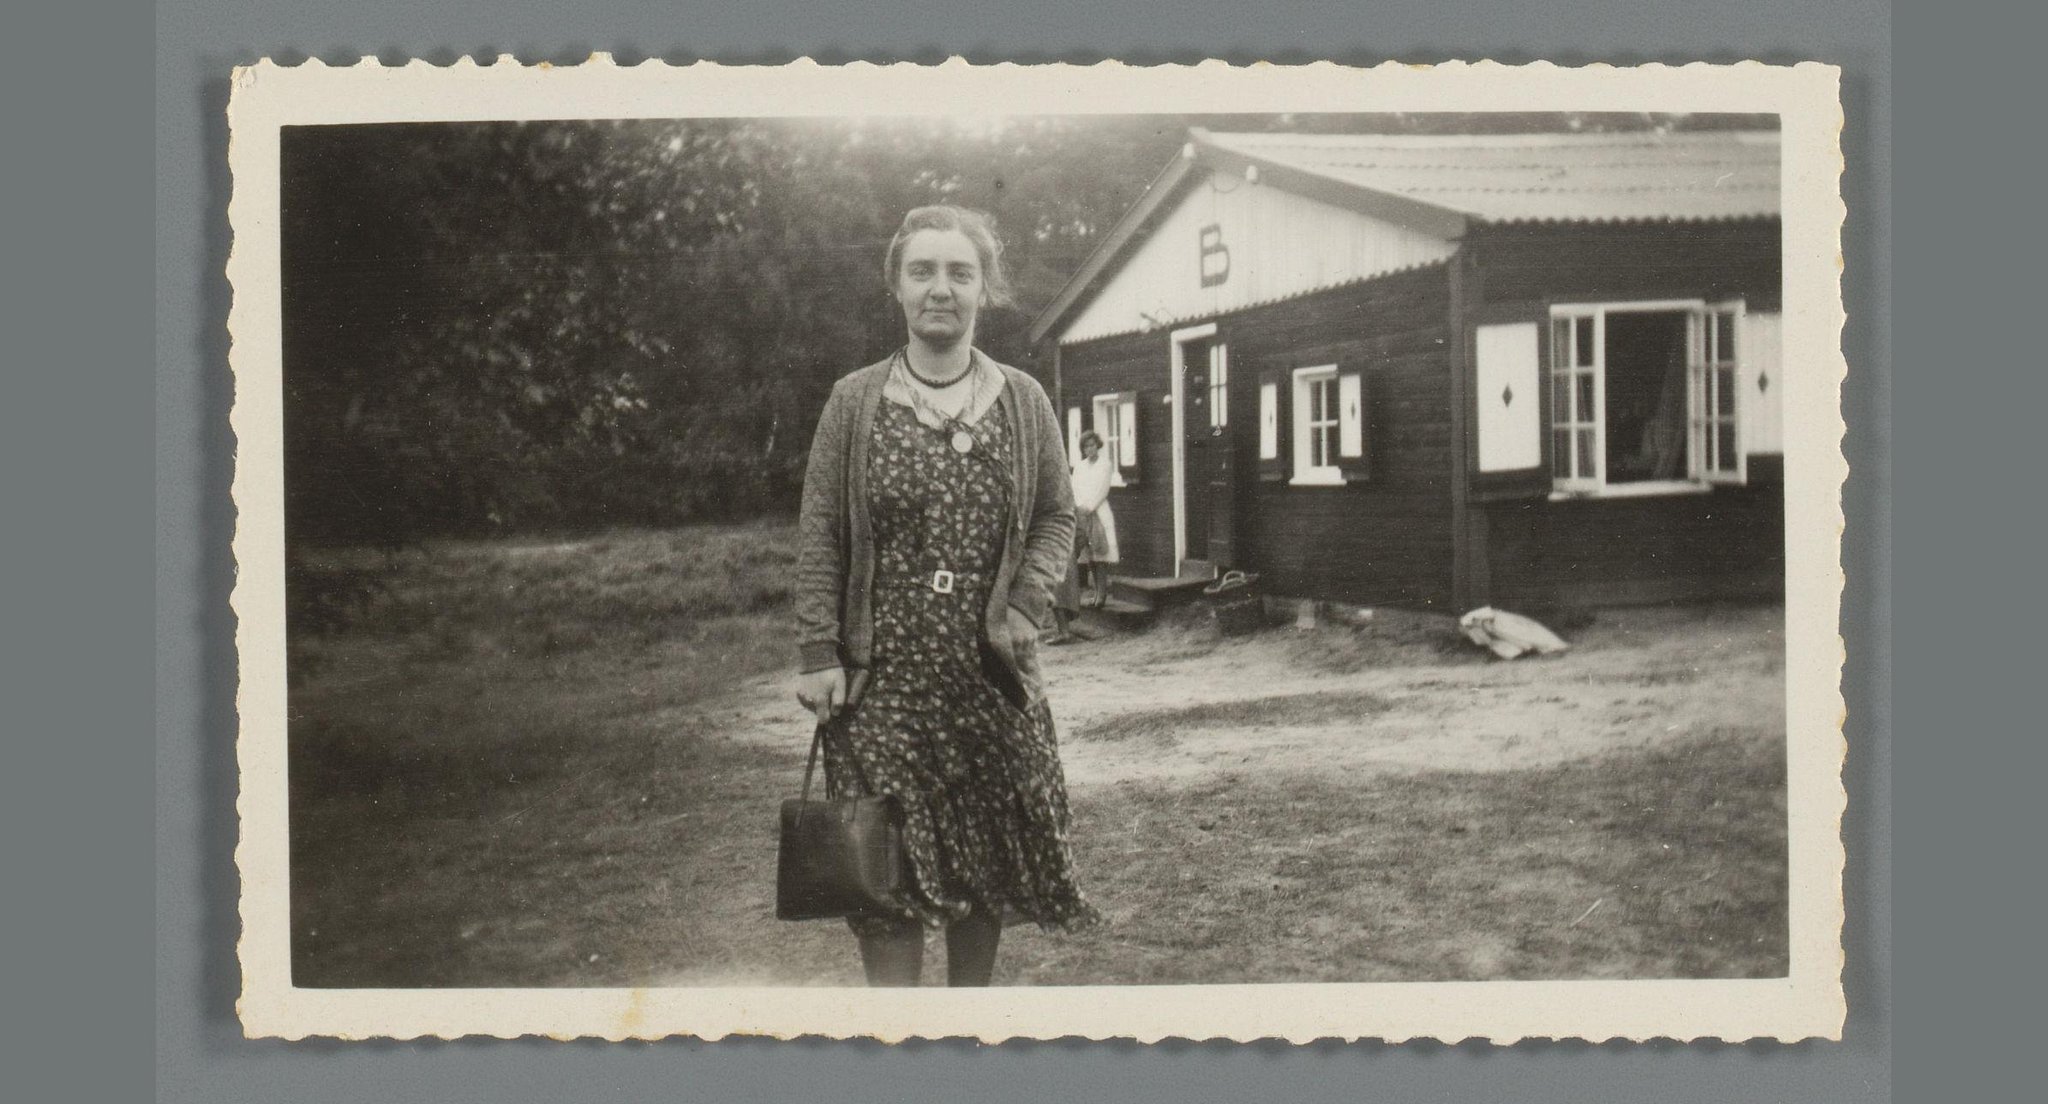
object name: photograph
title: Portret van een onbekende vrouw in Lunteren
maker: Anonymous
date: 1908-1931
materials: paper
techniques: gelatin silver print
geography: lunteren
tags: historical persons not known by name - bb - woman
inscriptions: number: ‘141’, inscription: ‘Lunteren/ 1931 Aug.’